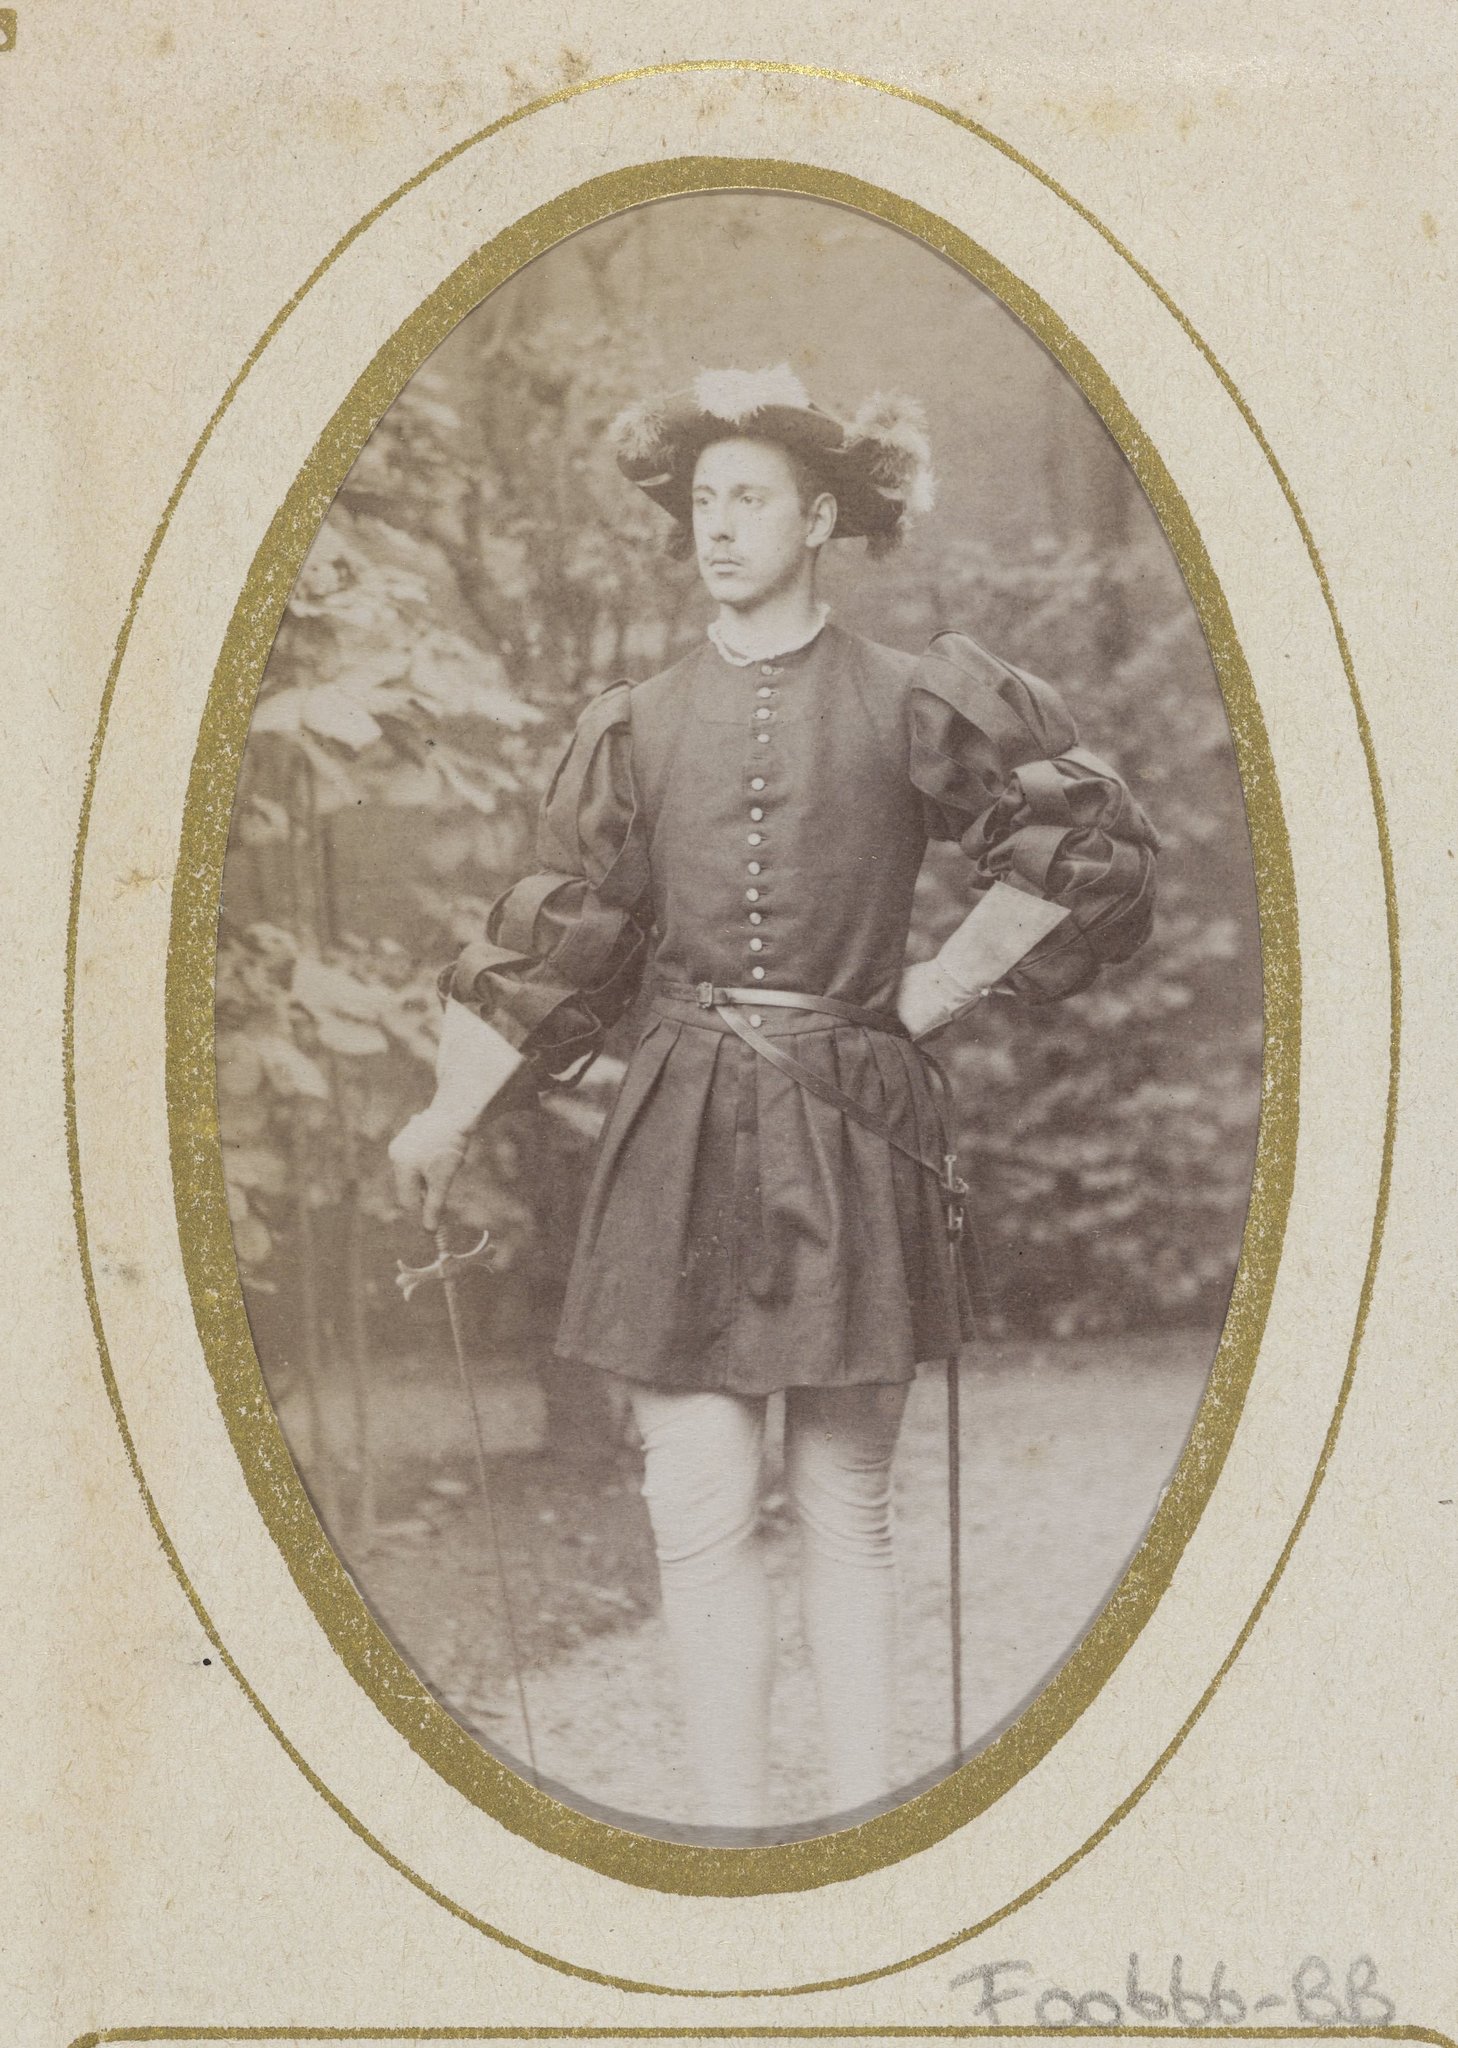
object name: photograph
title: Portret van een jonge man in kostuum met degen, aangeduid als M.M. de Monchy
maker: Anonymous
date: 1850-1900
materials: cardboard, photographic support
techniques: albumen print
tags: historical persons, historical costume, hacking and thrusting weapons: rapier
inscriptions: name: ‘M. M. de Monchy./ 76.’